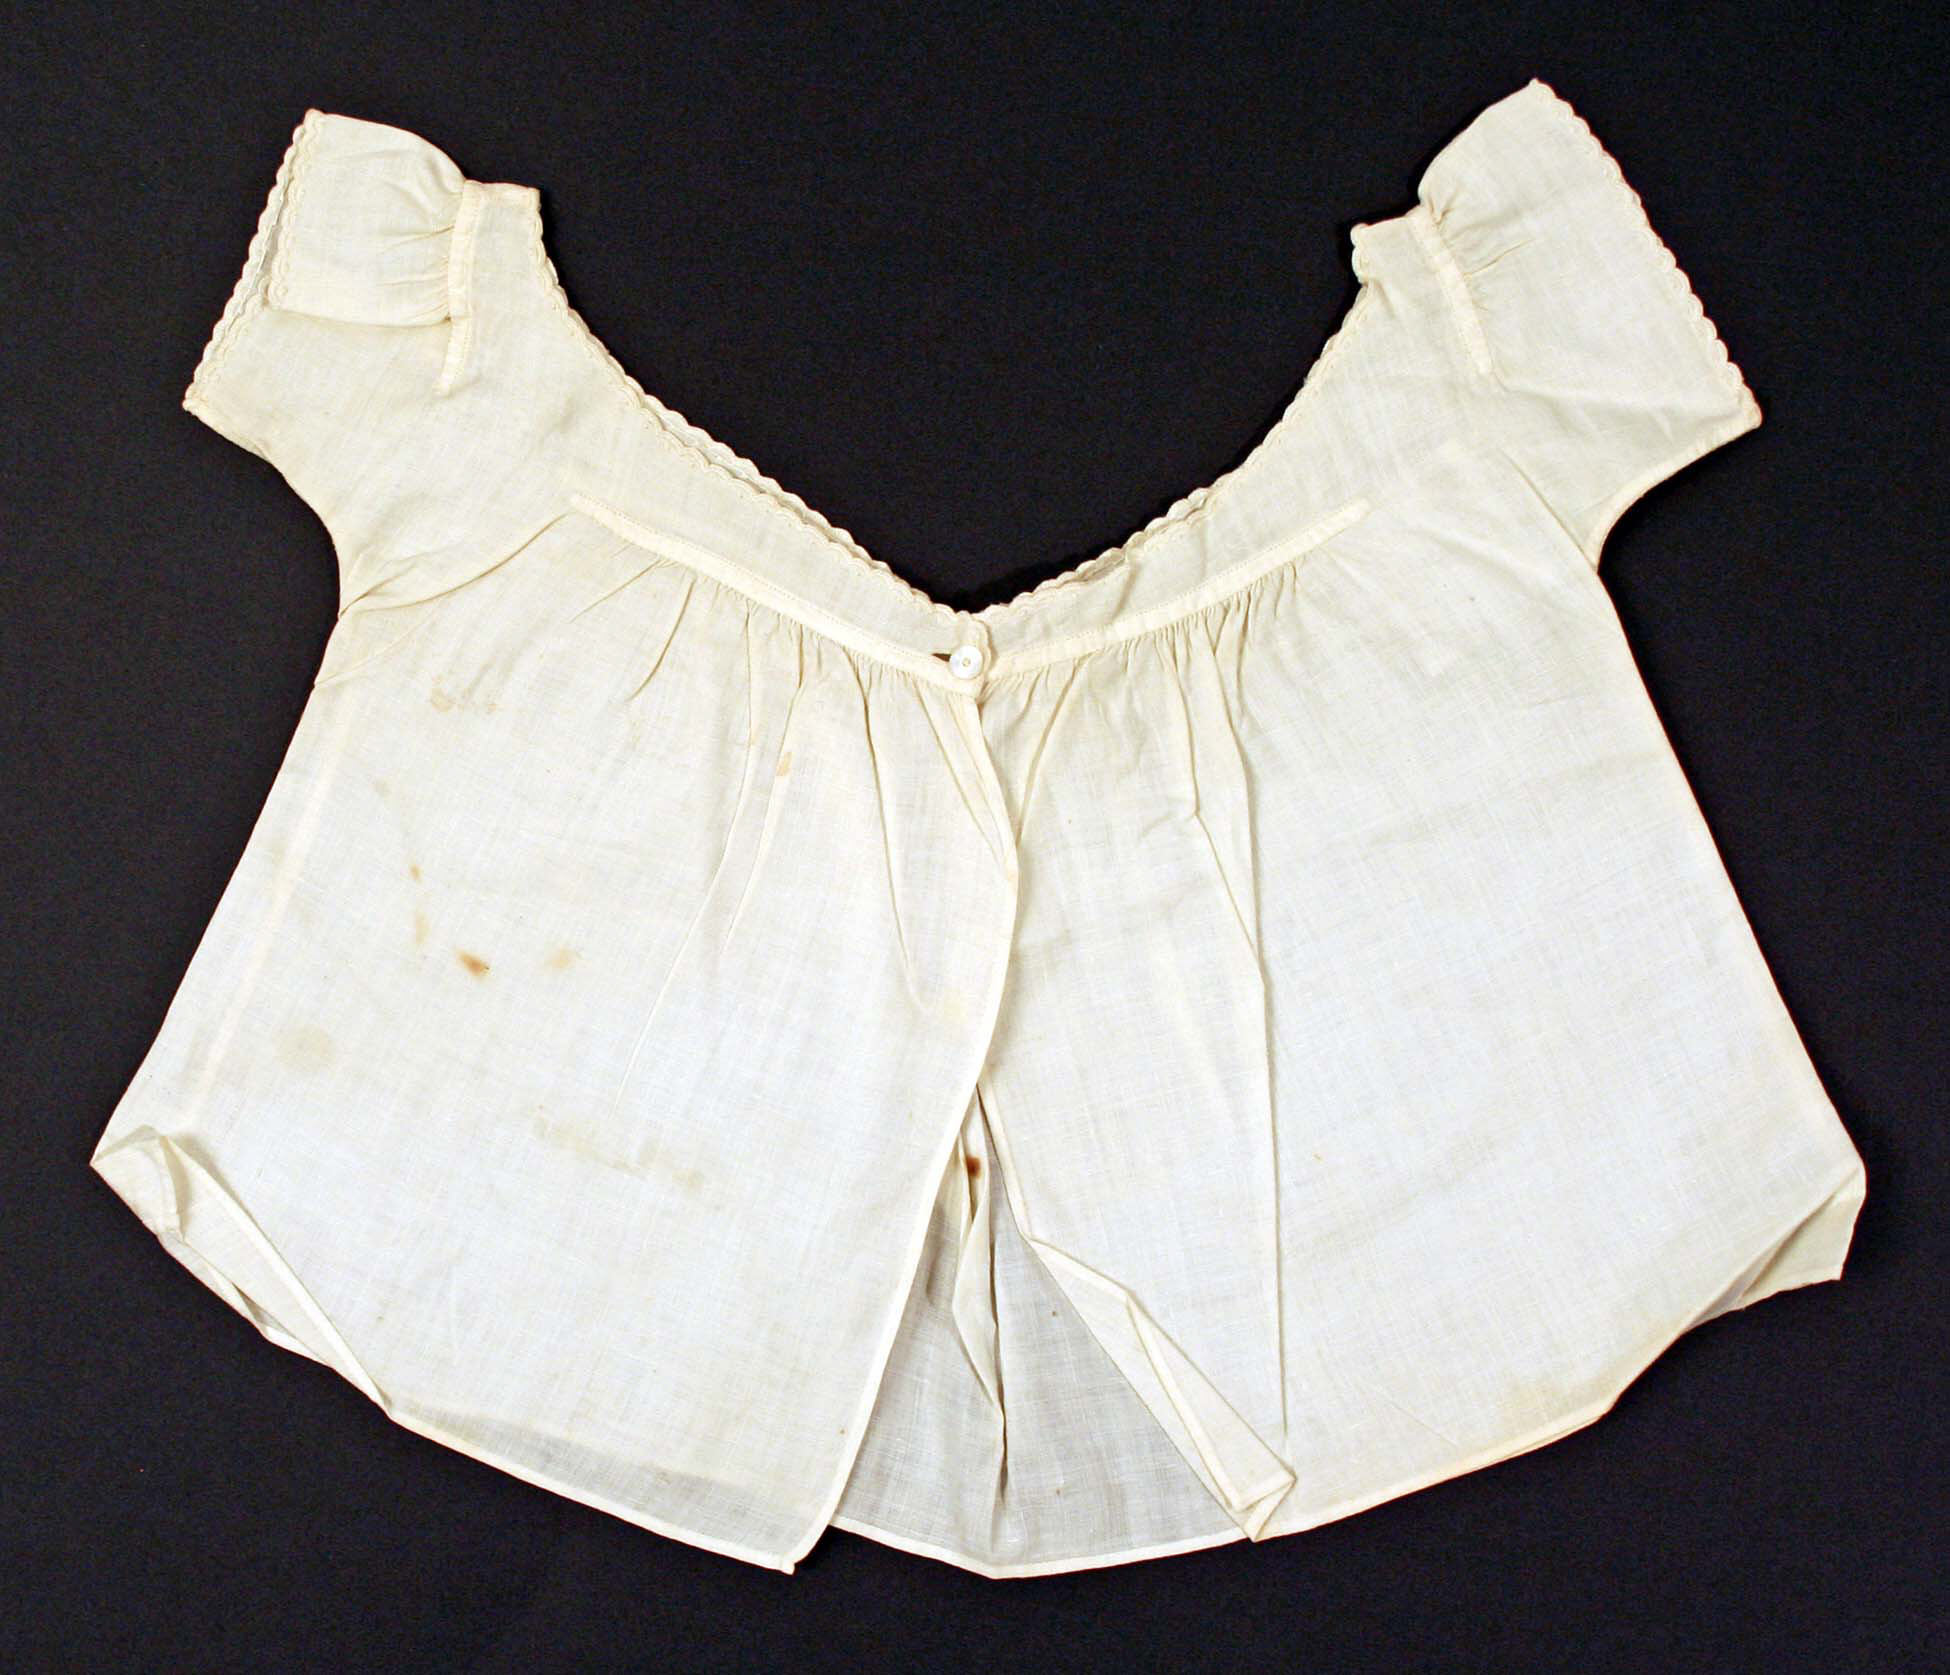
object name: shirt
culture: american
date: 1801-1833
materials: linen